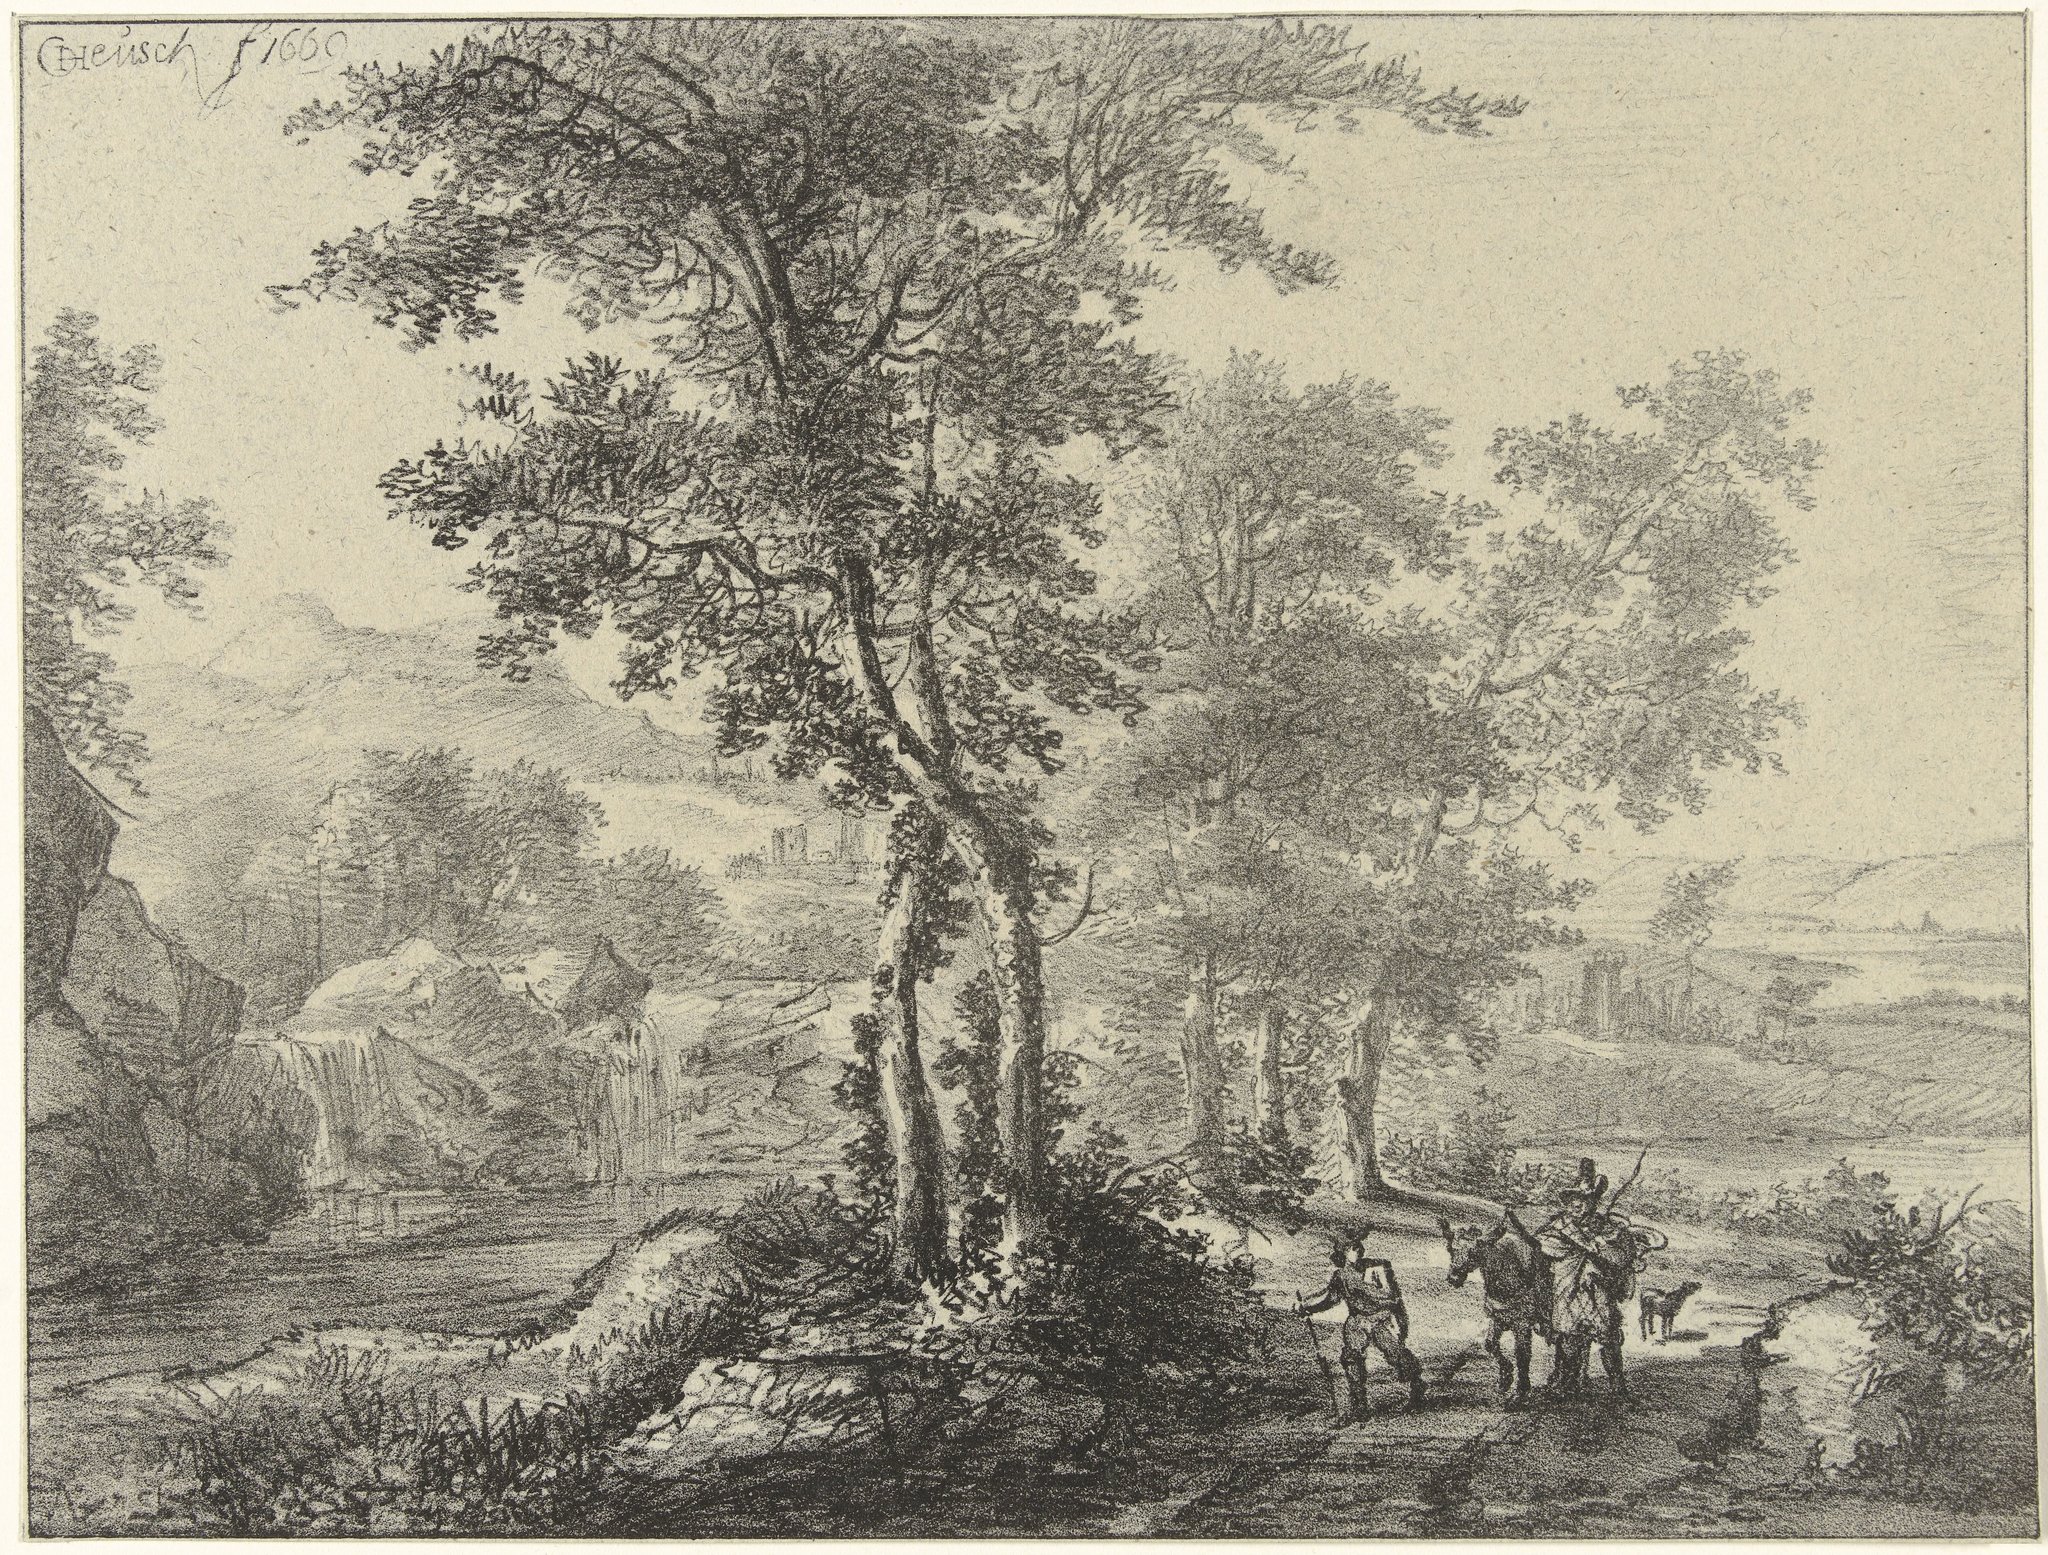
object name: print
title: Bosrijk landschap met reizigers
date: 1821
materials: paper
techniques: printmaking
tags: landscapes (+ landscape with figures, staffage)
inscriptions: collector's mark: Lugt 12, collector's mark: Lugt 2725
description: Door Christiaan Josi opgenomen in een uitgave met 100 werken naar Hollandse en Vlaamse meesters: Collection d'imitations de dessins d'après les principaux maîtres hollandais et flamands, Londen, C.Josi, 1821. Alle prenten in deze uitgave dragen op het verso het wapen van Cornelis Ploos van Amstel, de initiatiefnemer voor de uitgave.